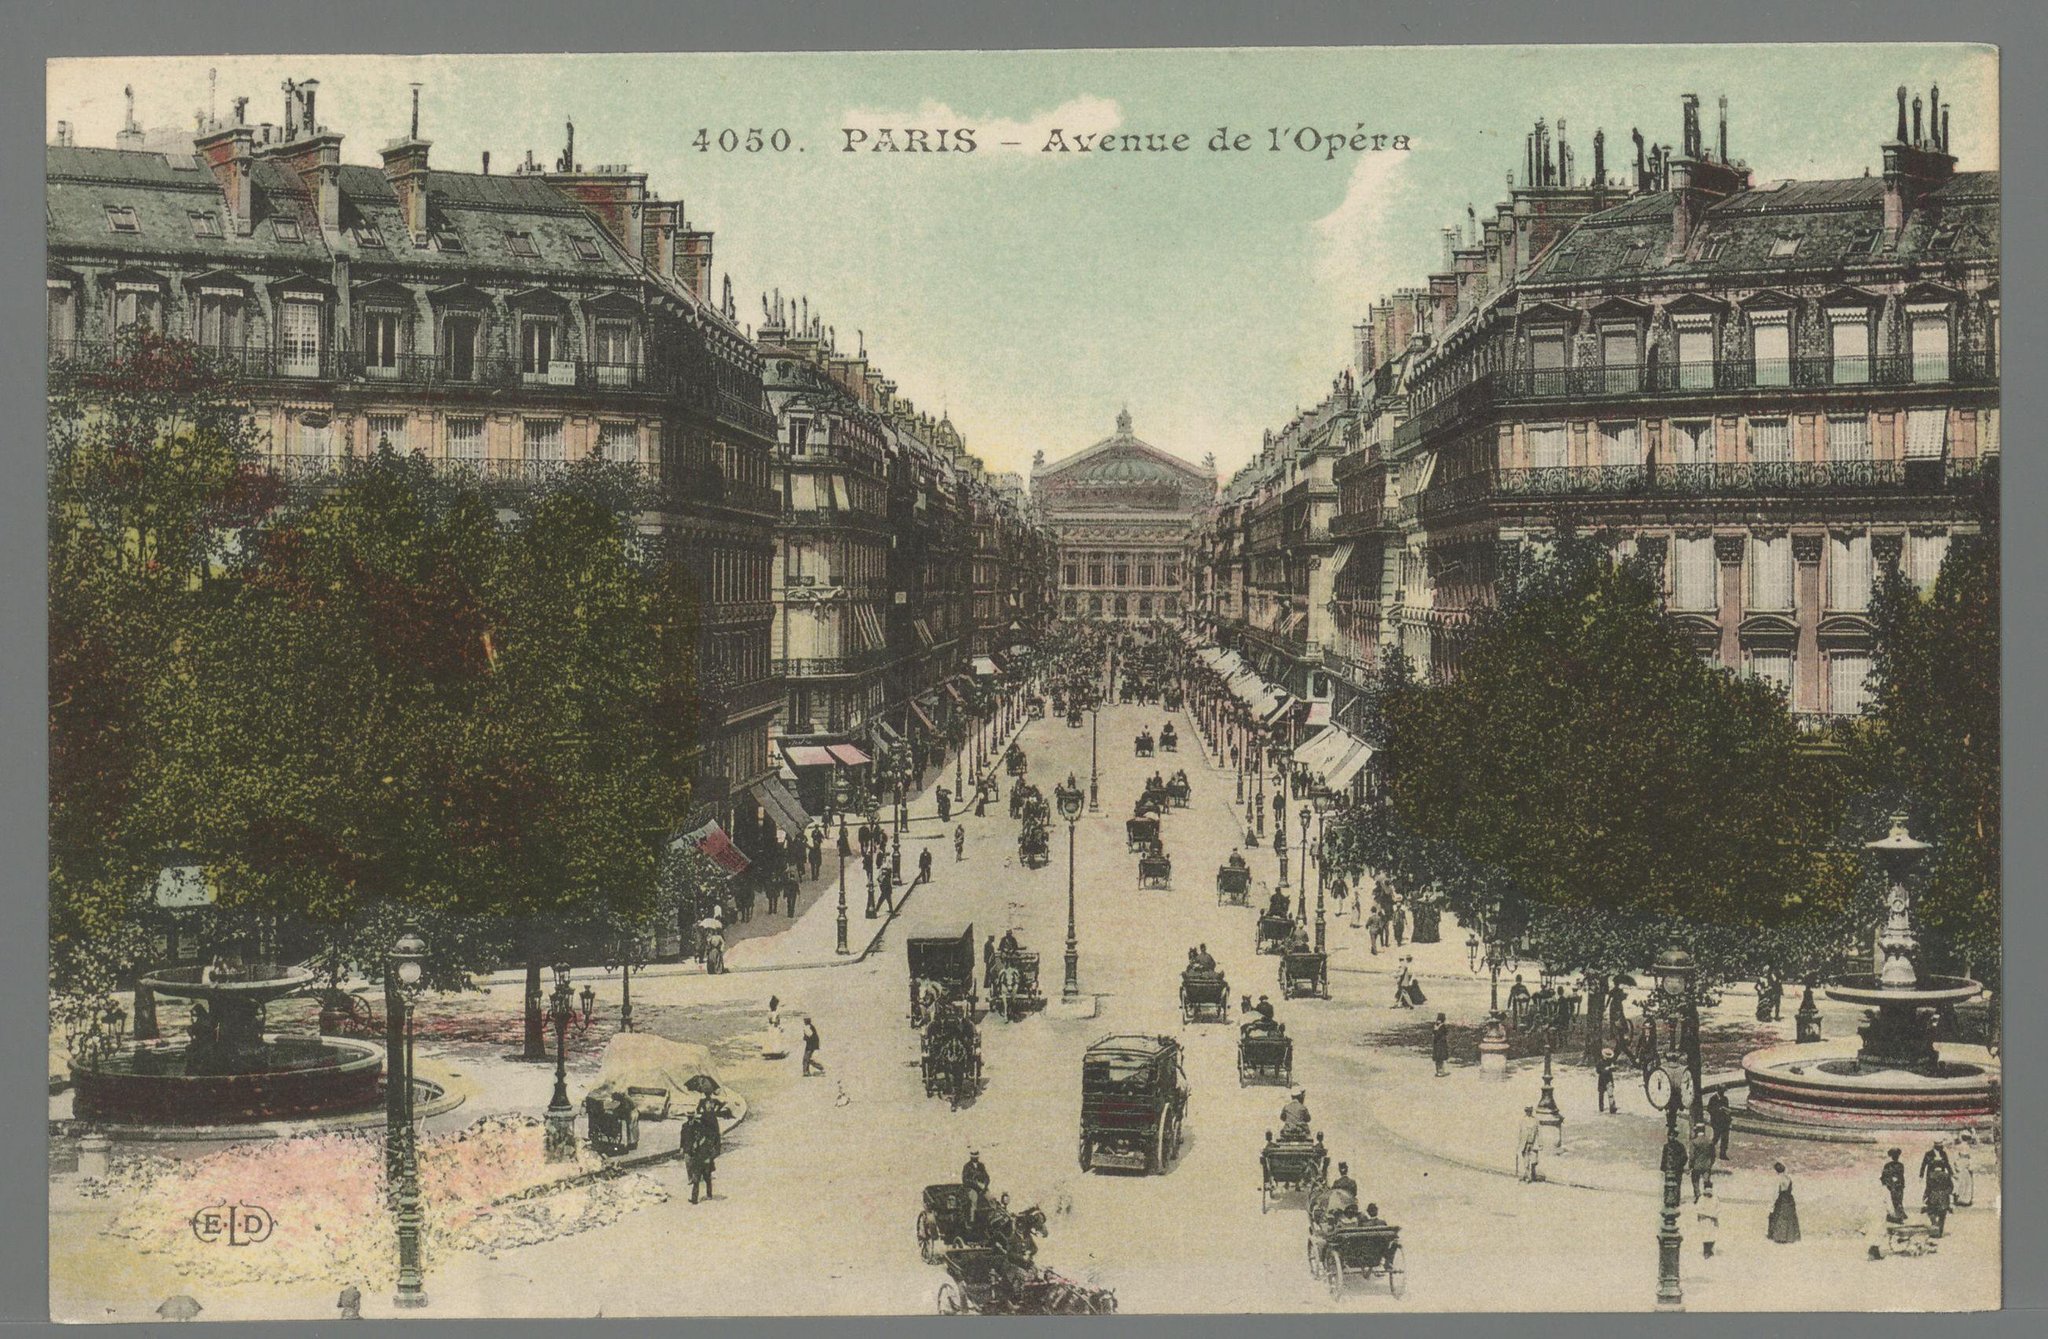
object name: ansichtkaart, prentbriefkaart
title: Paris. Avenue de l'Opéra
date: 1904-1906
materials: cardboard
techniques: photograph, lithograph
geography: paris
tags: avenue, boulevard, promenade, esplanade (+ city(-scape) with figures, staffage), opera house